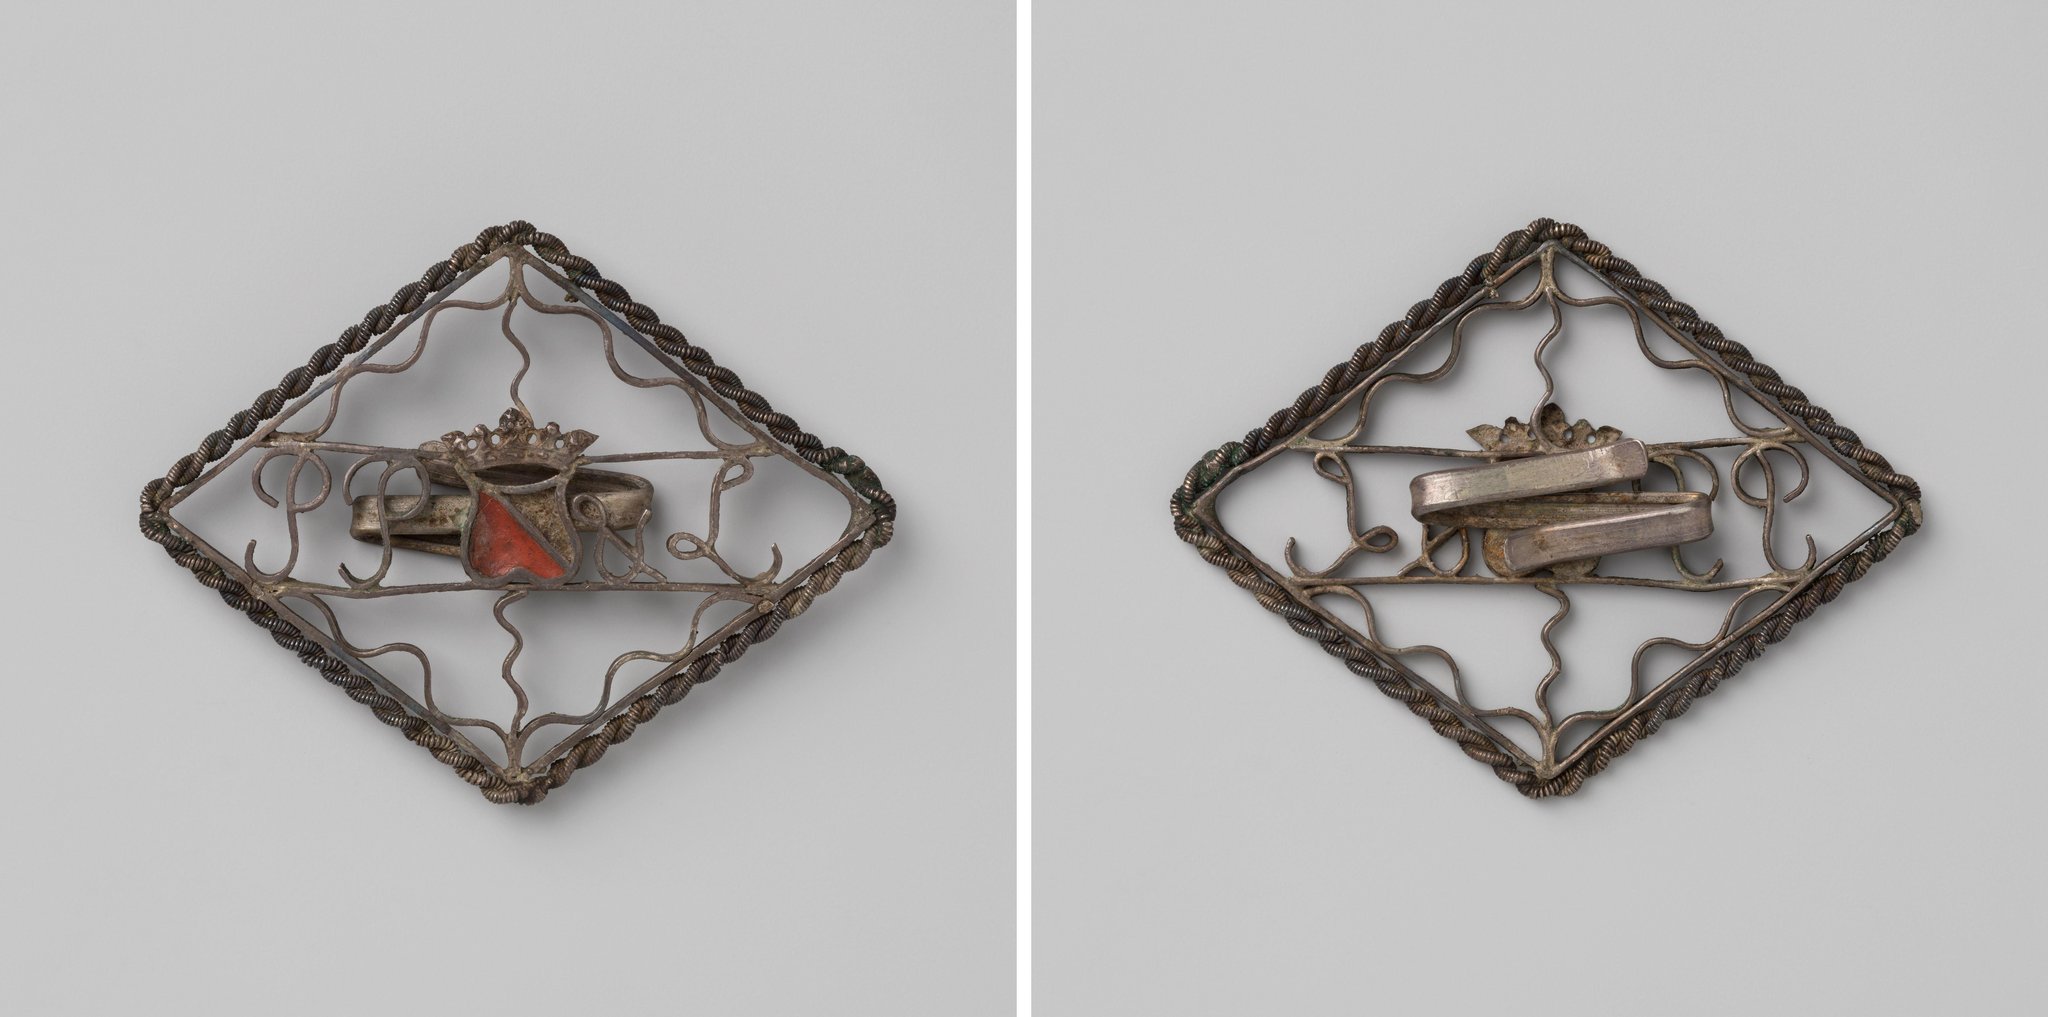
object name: insignia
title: Utrechts wapengenootschap Pro Patria et Libertate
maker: Anonymous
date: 1784-1787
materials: silver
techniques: sawing, striking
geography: netherlands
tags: utrecht